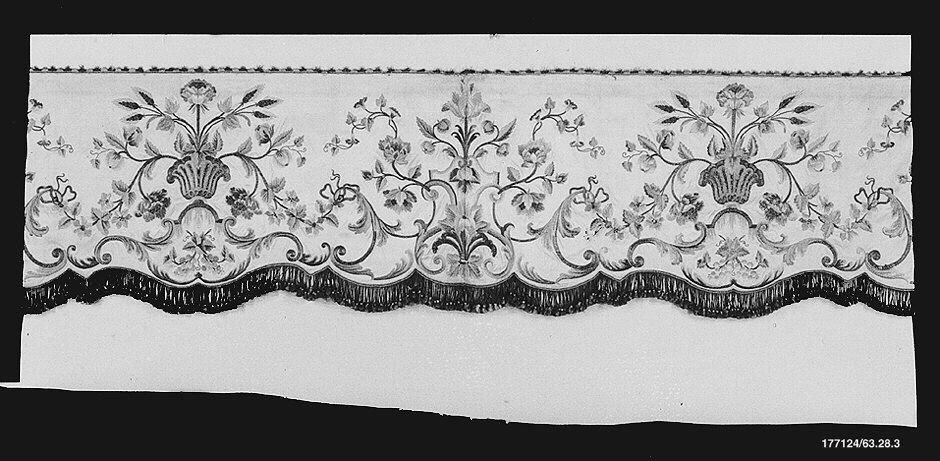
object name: valance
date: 1701-1800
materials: metal, silk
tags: flowers